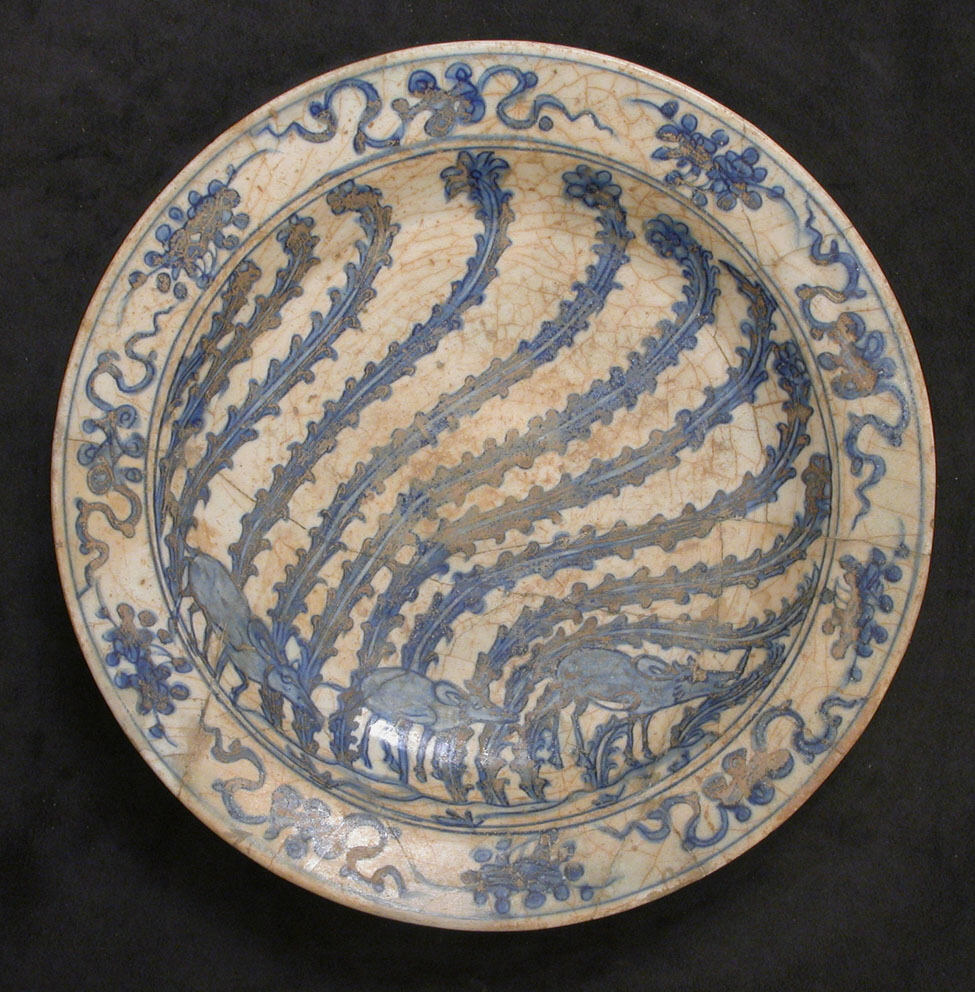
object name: dish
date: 1501-1600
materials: pottery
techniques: glazing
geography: iran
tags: animals